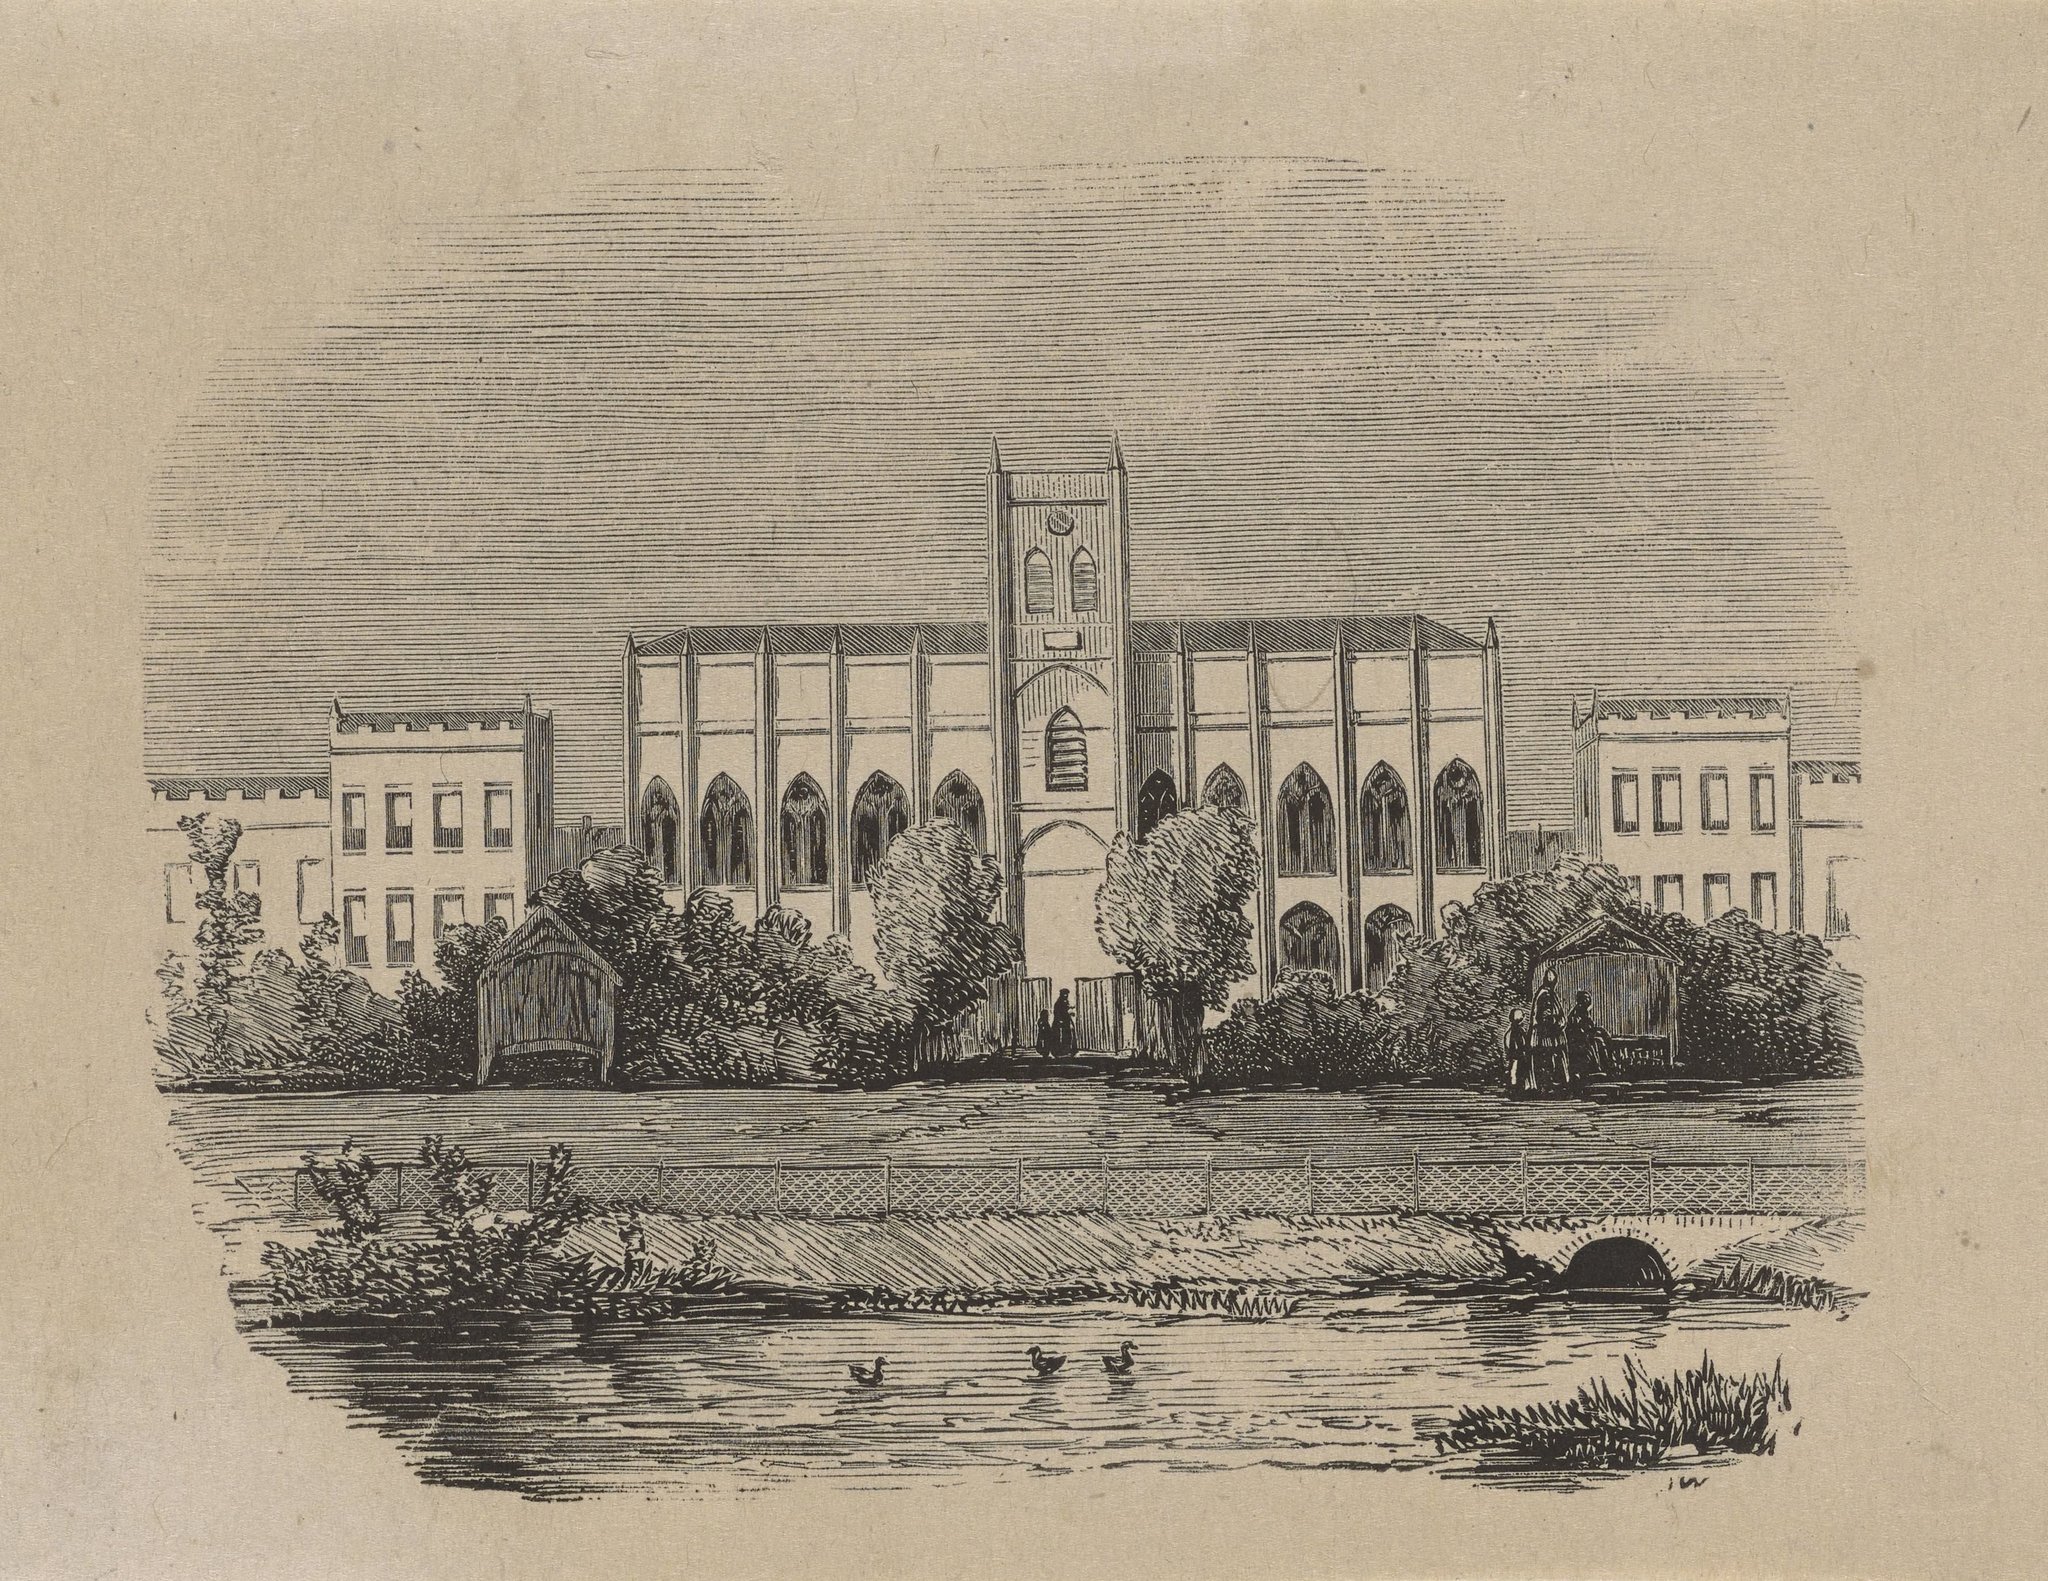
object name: print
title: Gezicht op een bouwwerk met gotische vensters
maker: isaac weissenbruch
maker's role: print maker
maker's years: 1826-1912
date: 1836-1912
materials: paper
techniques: engraving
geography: netherlands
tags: civic architecture; edifices; dwellings